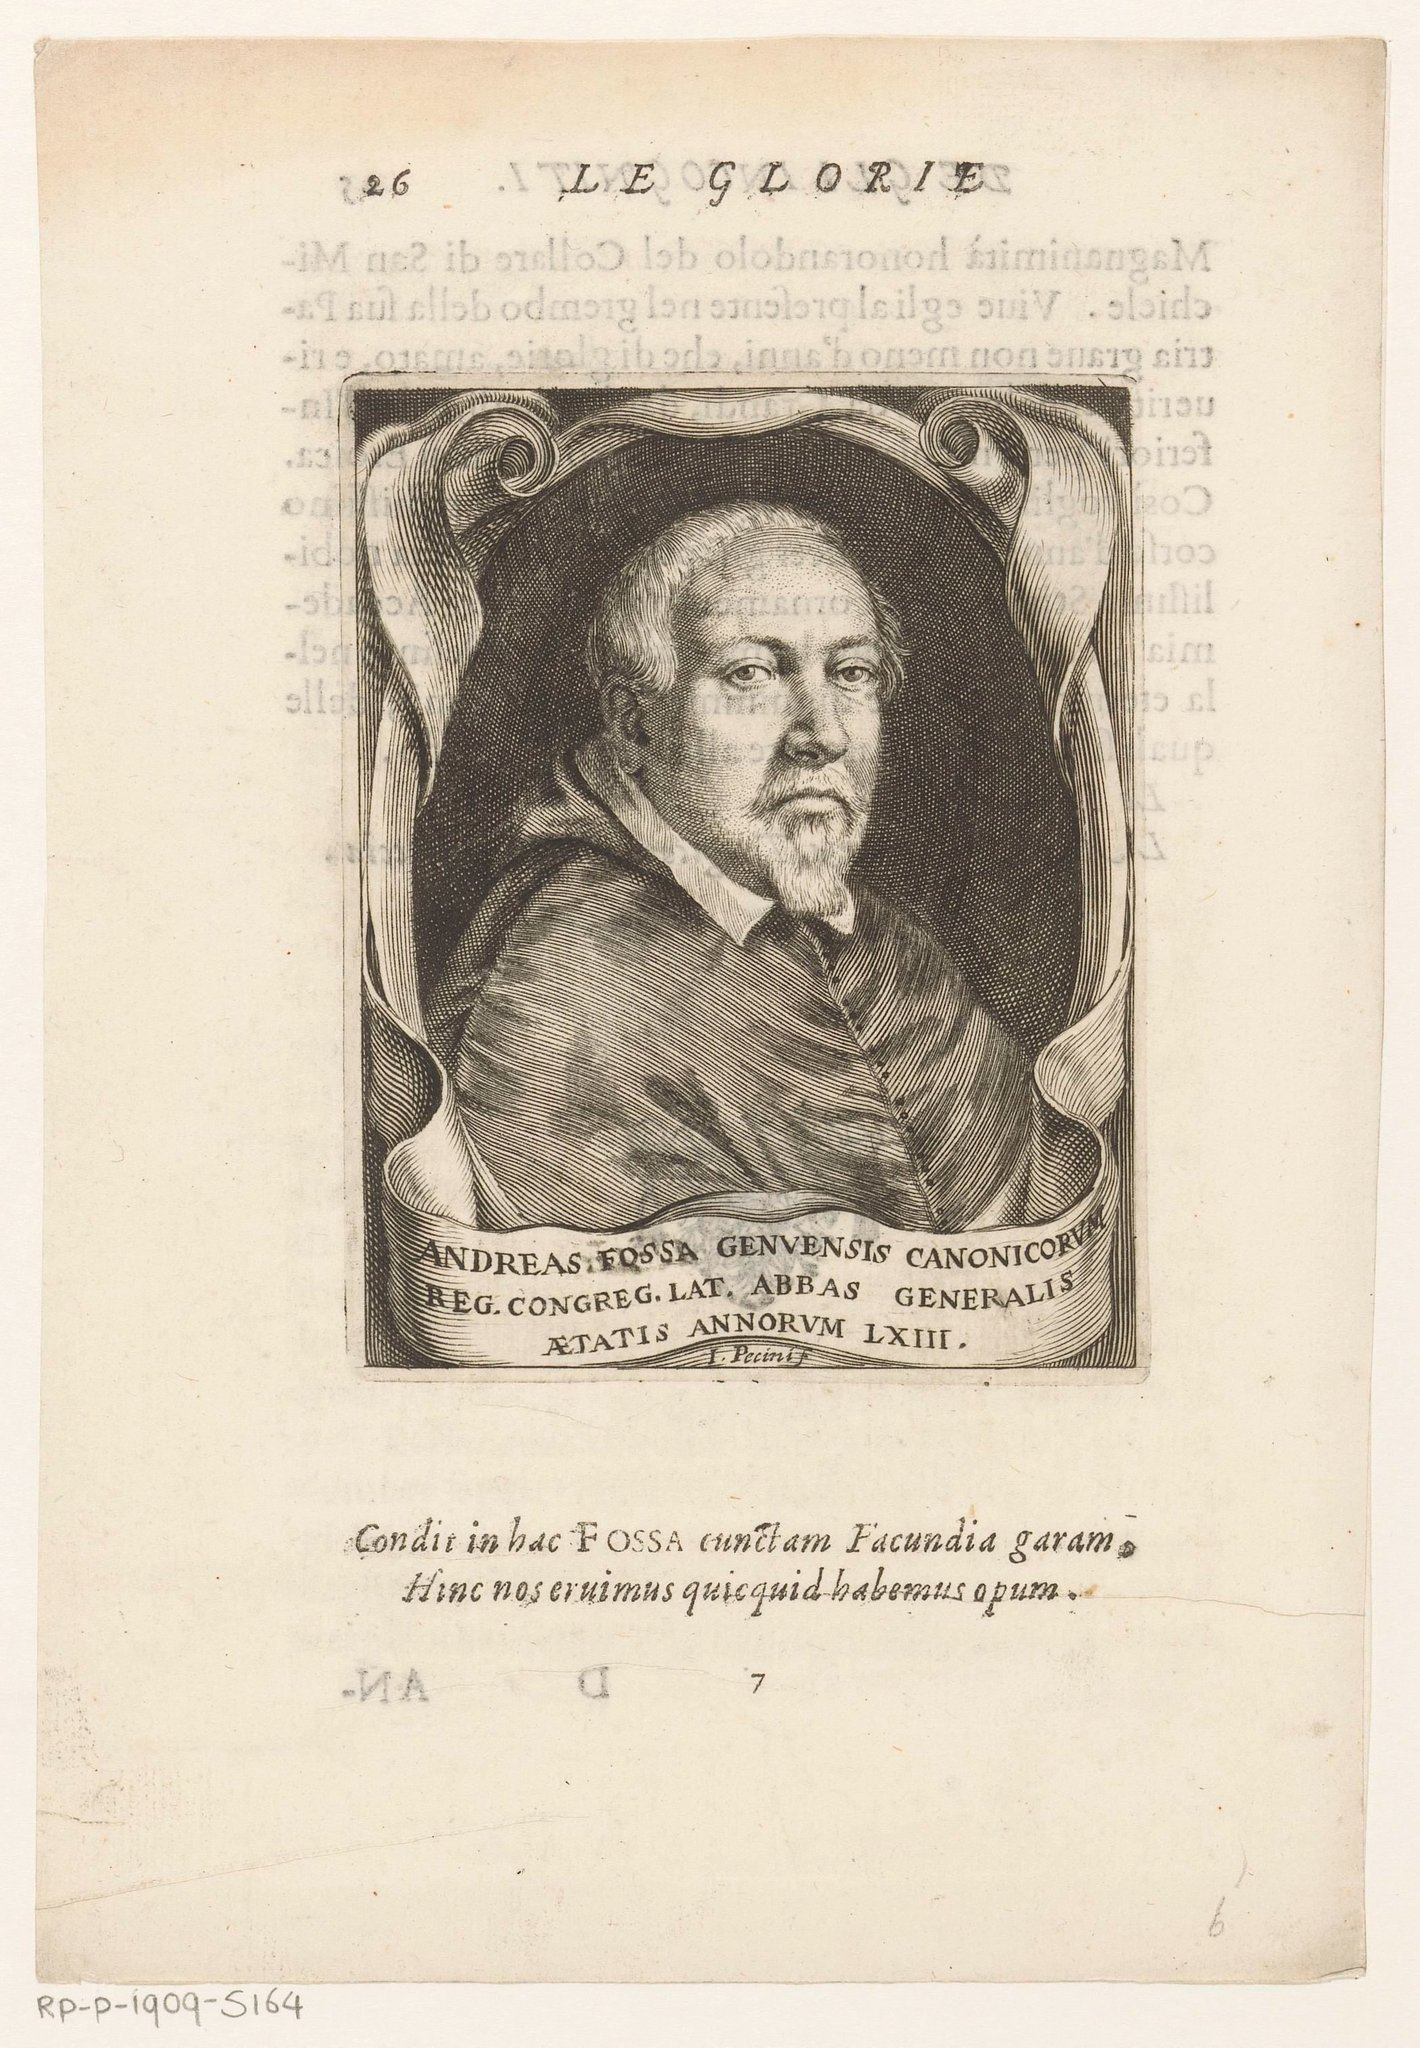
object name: print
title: Portret van kanunnik Andrea Fossa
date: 1647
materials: paper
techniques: engraving, letterpress printing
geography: venice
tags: historical persons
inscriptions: collector's mark: Lugt 2228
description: Prent uit de publicatie: Loredan, Giovan Francesco. Le glorie degli Incogniti. Venetië: Francesco Valvasense, 1647, p. 26.